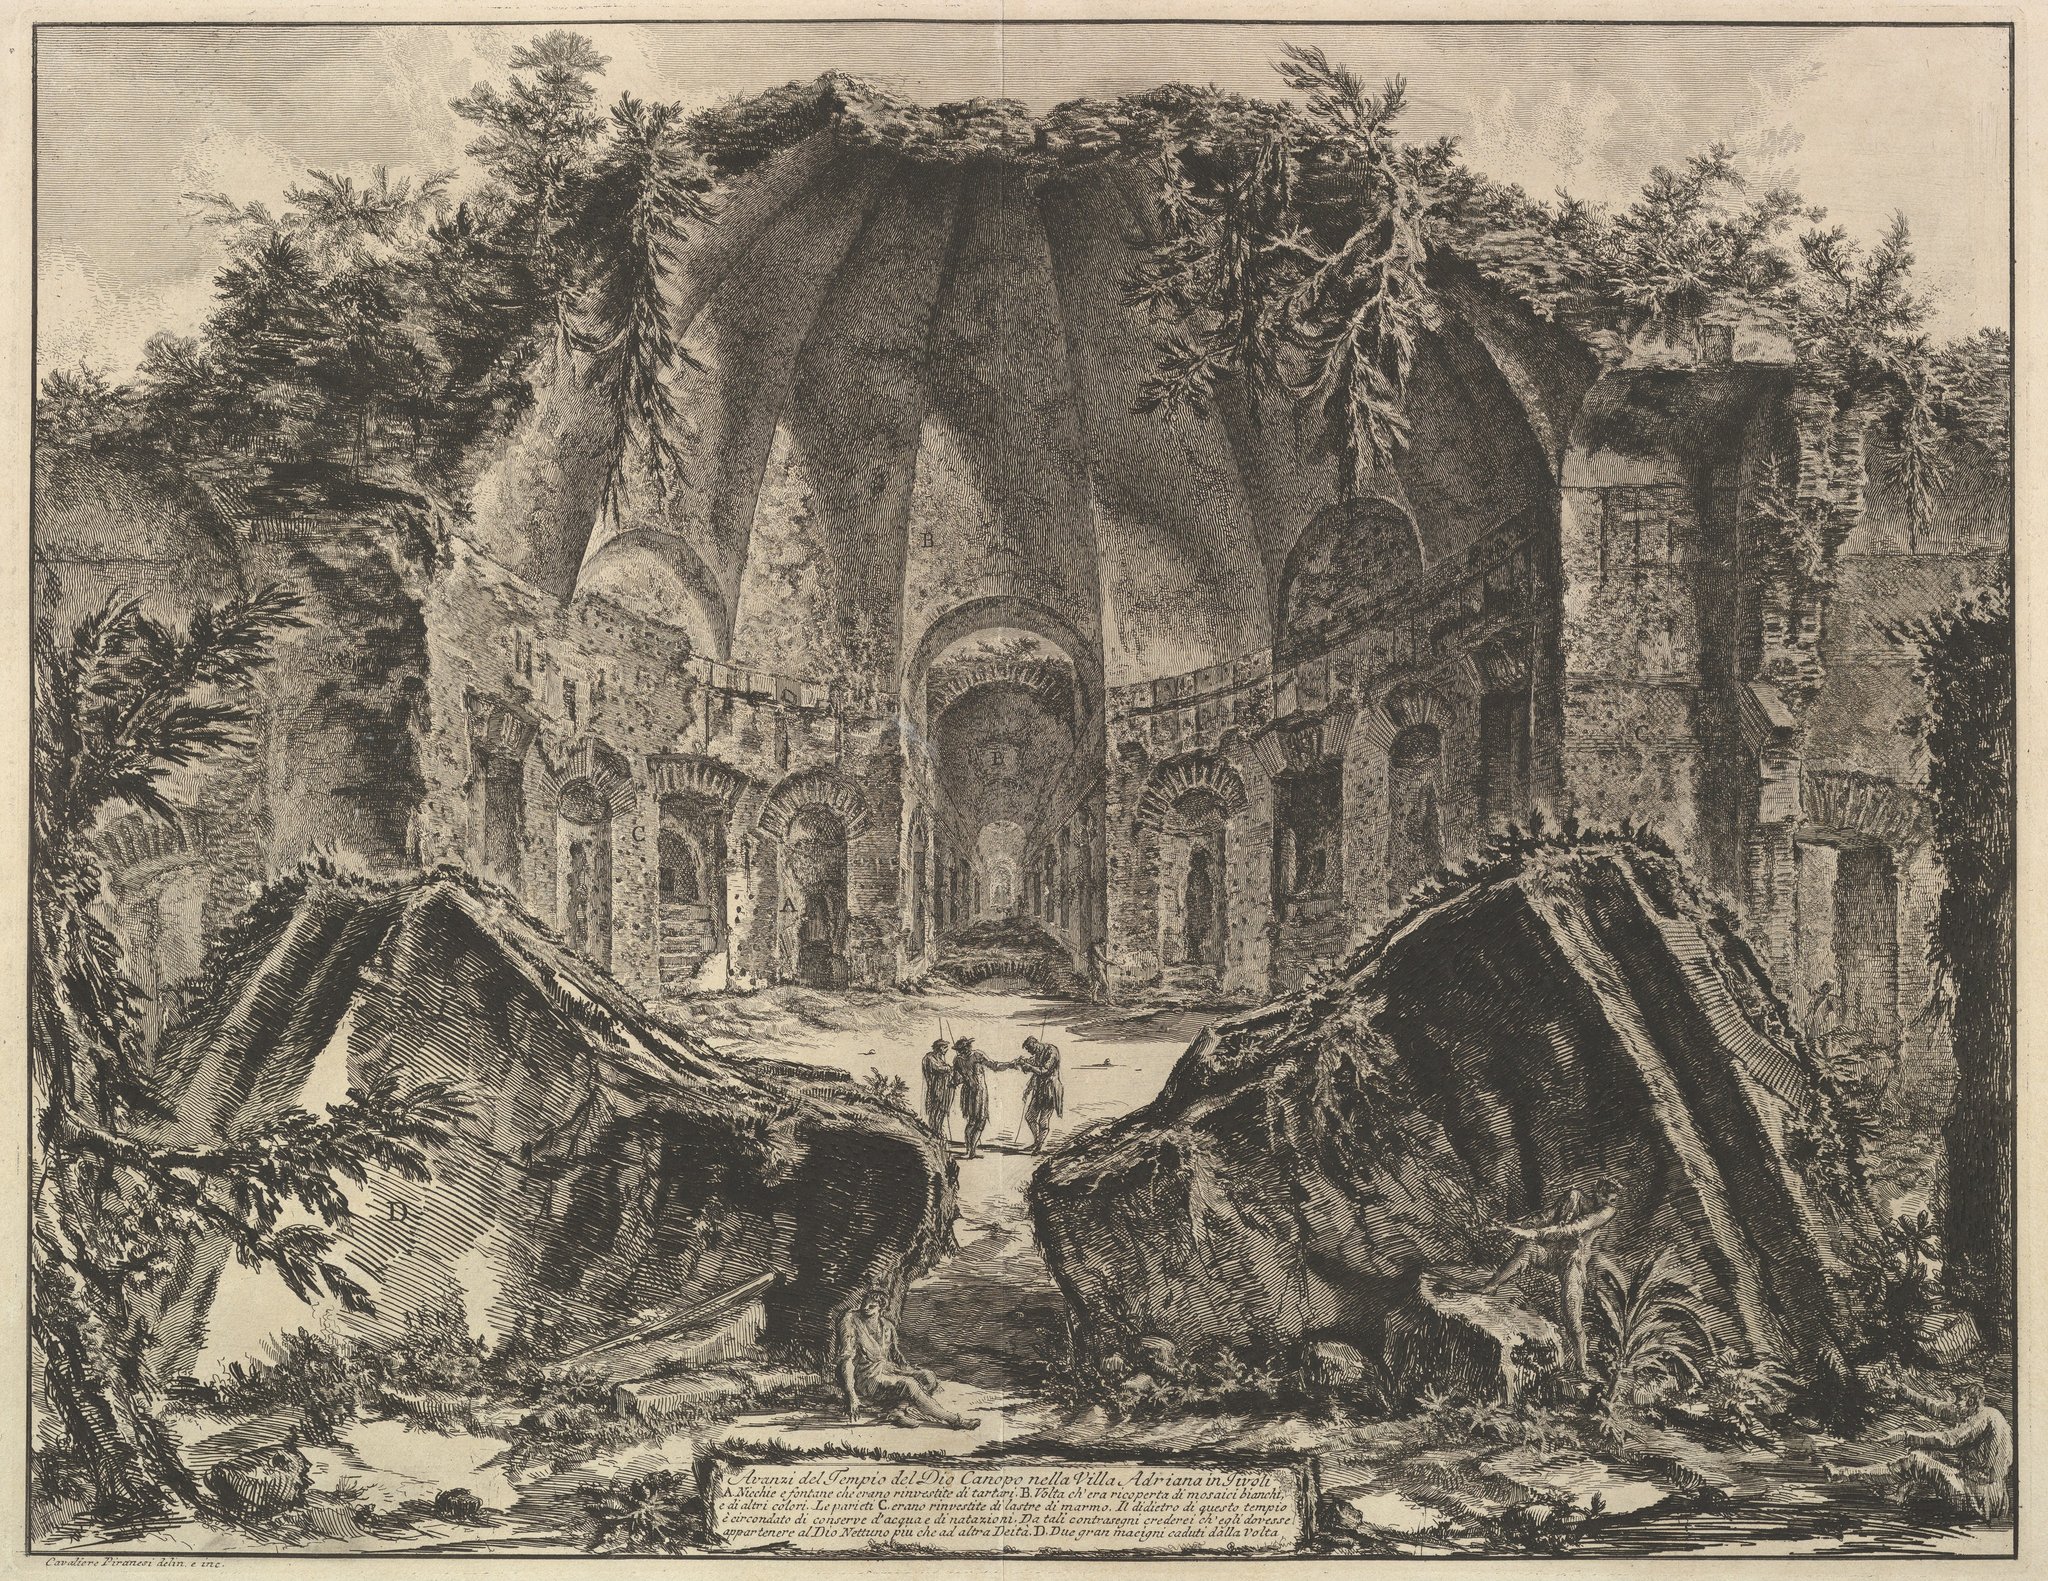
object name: print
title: Hadrian's Villa: The Canopus (Avanzi del Tempio Dio Canopo nella Villa Adriana in Tivoli)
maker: giovanni battista piranesi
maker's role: artist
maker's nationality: italian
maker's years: 1720-1778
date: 1769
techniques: etching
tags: human figures,architecture